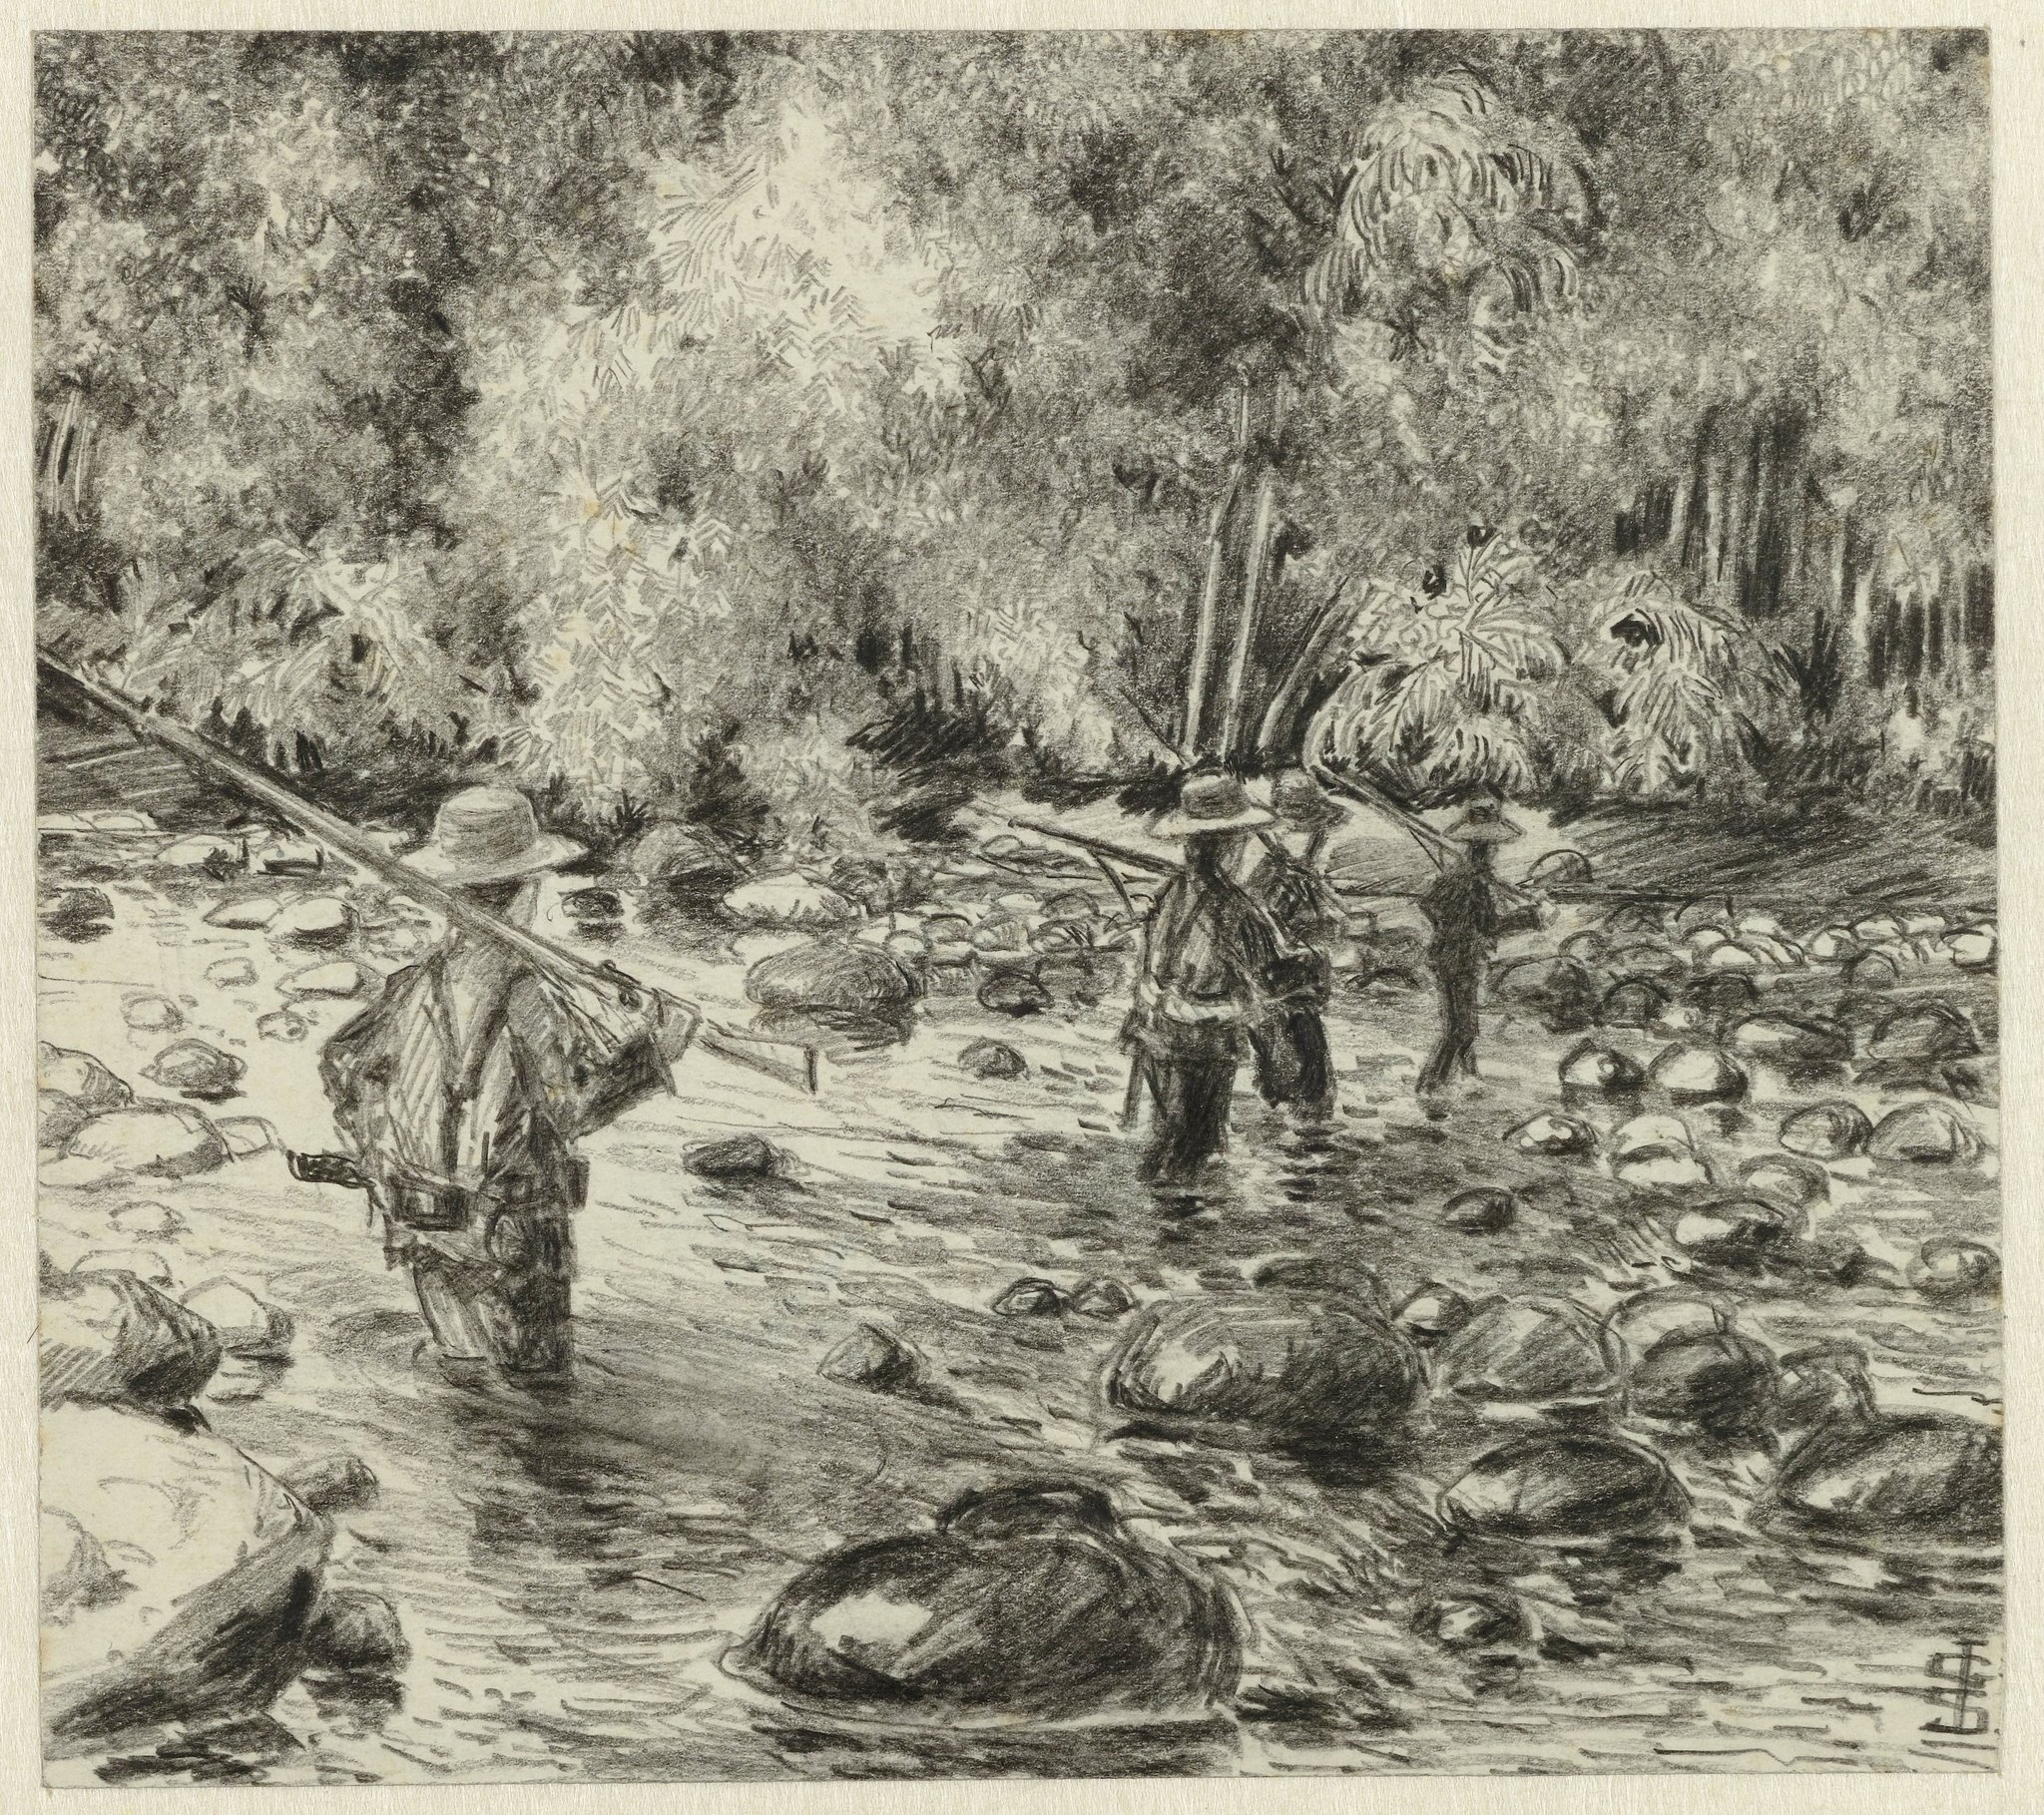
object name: drawing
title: Soldaten die door rivier waden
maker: johan gerard sinia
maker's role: draughtsman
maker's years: 1875-1948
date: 1900-1910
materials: chalk, paper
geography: south celebes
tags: hoorn (north holland), johan gerard sinia, military service, landscapes in tropical and sub-tropical regions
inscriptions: signature: ‘JGS’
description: J. G. Sinia was KNIL-officier, auteur en kunstenaar. Hij bezocht de buitenposten van Nederlands-Indië in de eerste jaren van de 20e eeuw. In april 1908 wordt Sinia overgeplaatst naar Zuidwest-Celebes. Hij wordt hier als militair en civiel gezaghebber aangesteld in het bebied Soppeng. Op 12 oktober 1909 keert hij terug naar Nederland.